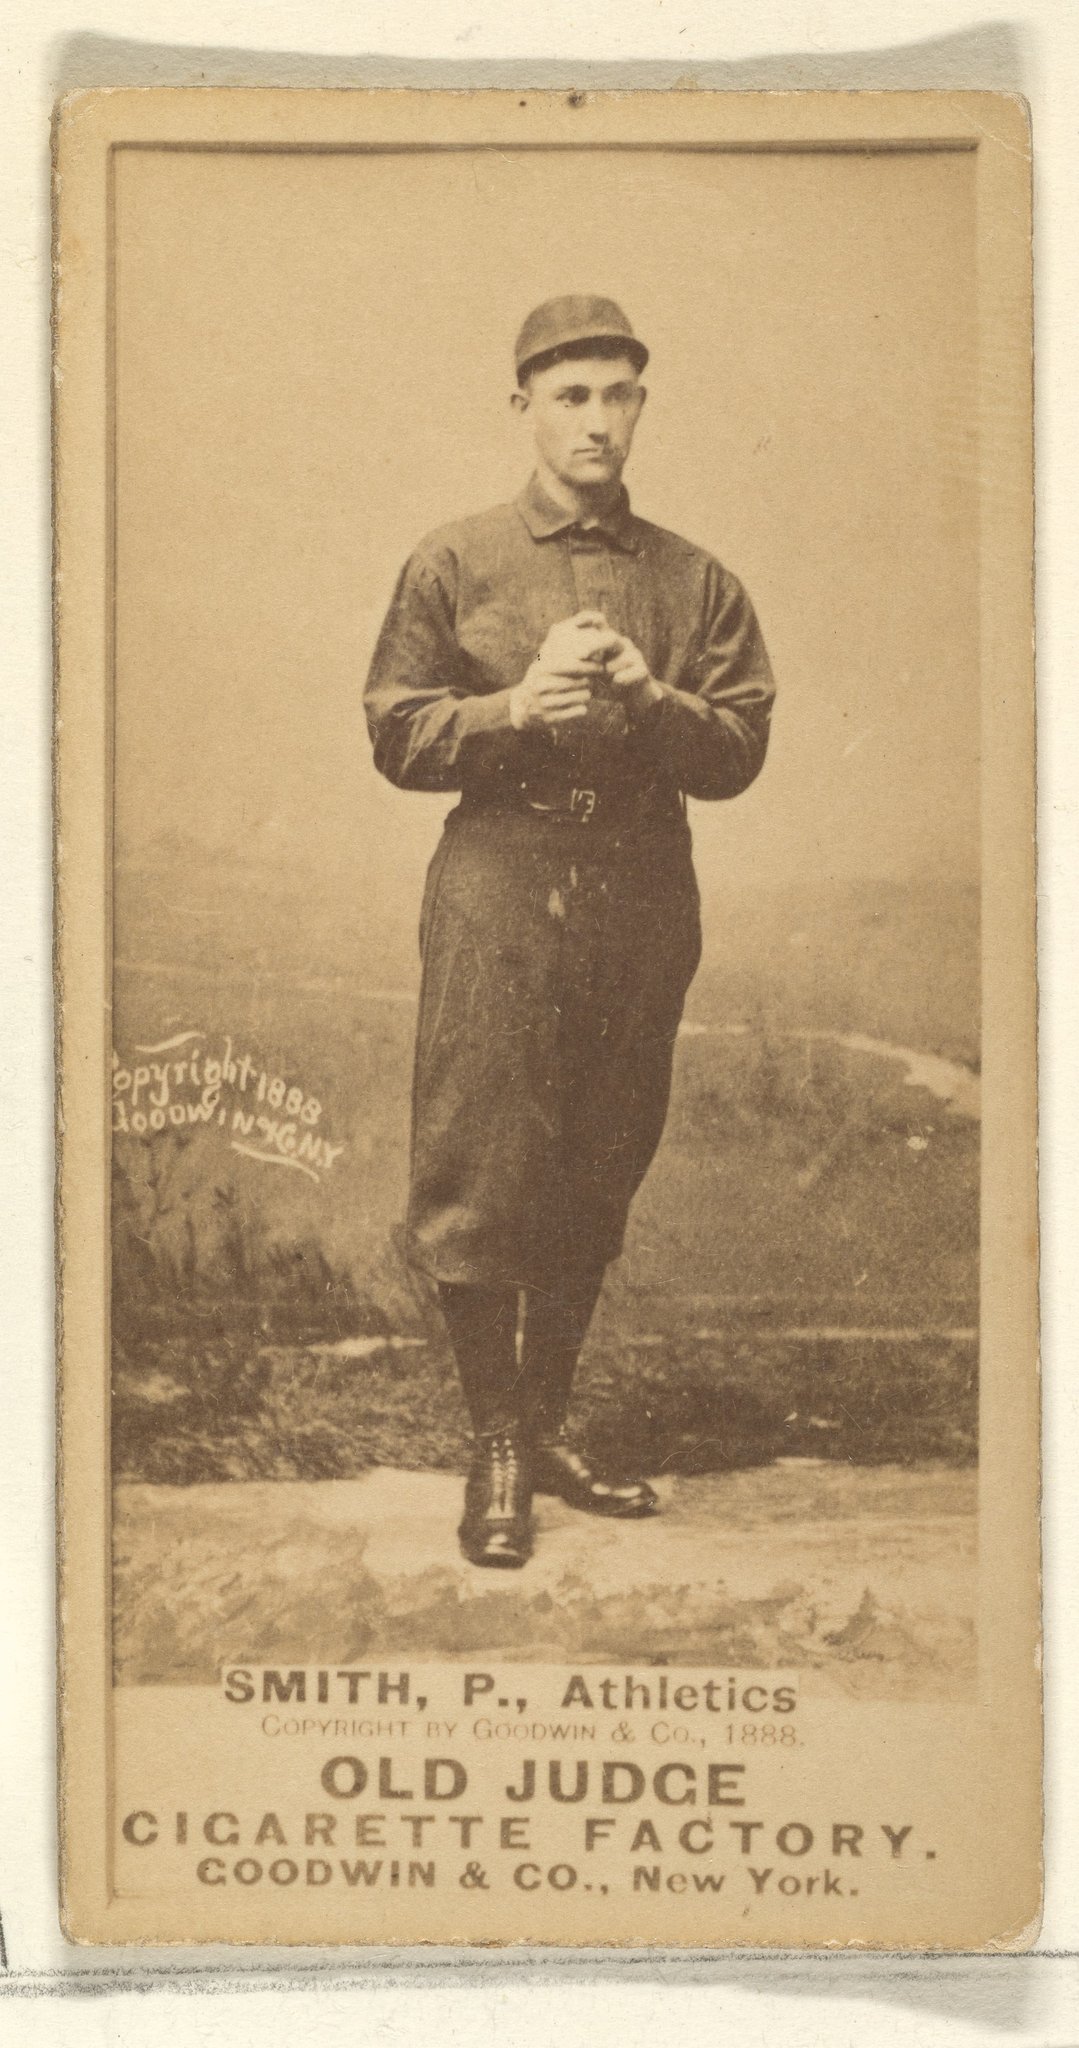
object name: baseball card, photograph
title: Smith, Pitcher, Philadelphia Athletics, from the Old Judge series (N172) for Old Judge Cigarettes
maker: goodwin & company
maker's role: publisher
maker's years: 1850-1950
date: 1888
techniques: albumen silver print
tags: men,portraits,baseball,athletes